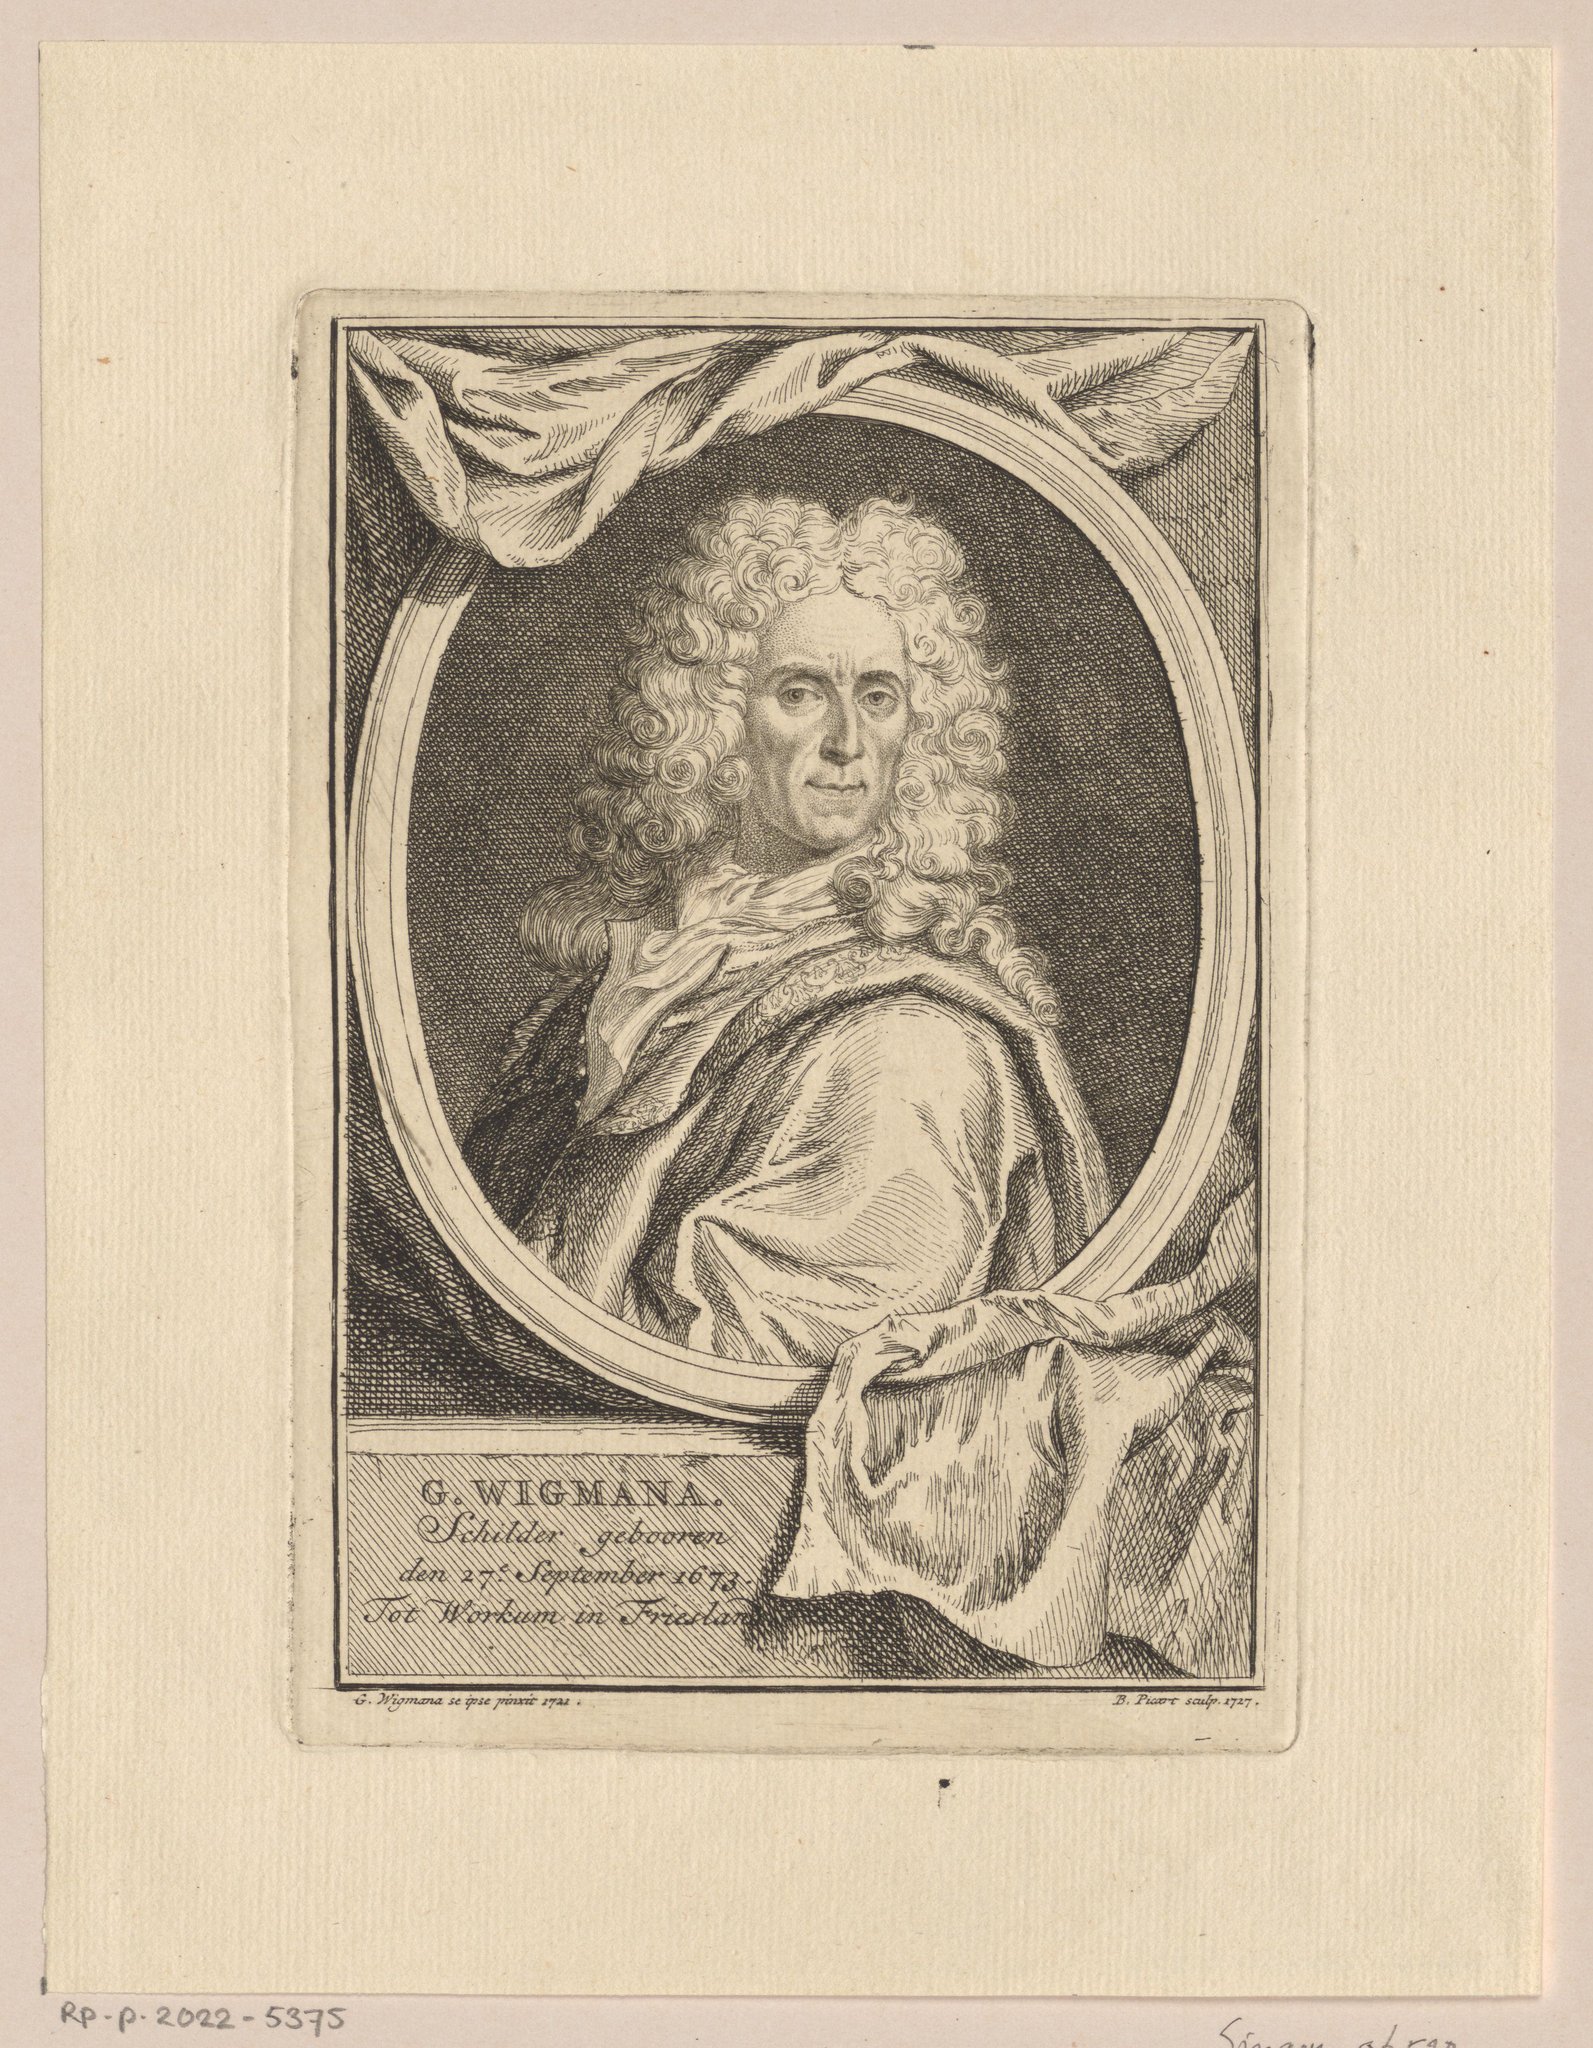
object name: print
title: Portret van Gerard Wigmana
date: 1727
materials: paper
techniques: etching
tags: amsterdam, print maker, gerard wigmana, historical persons, portrait, self-portrait of painter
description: Prent waarschijnlijk uit: Wigmana, Gerard. Korte schets of denkbeeld om tot een groote volmaaktheid in de schilderkonst te gerake (...). Amsterdam: Jacobus Ryckhoff, 1742.